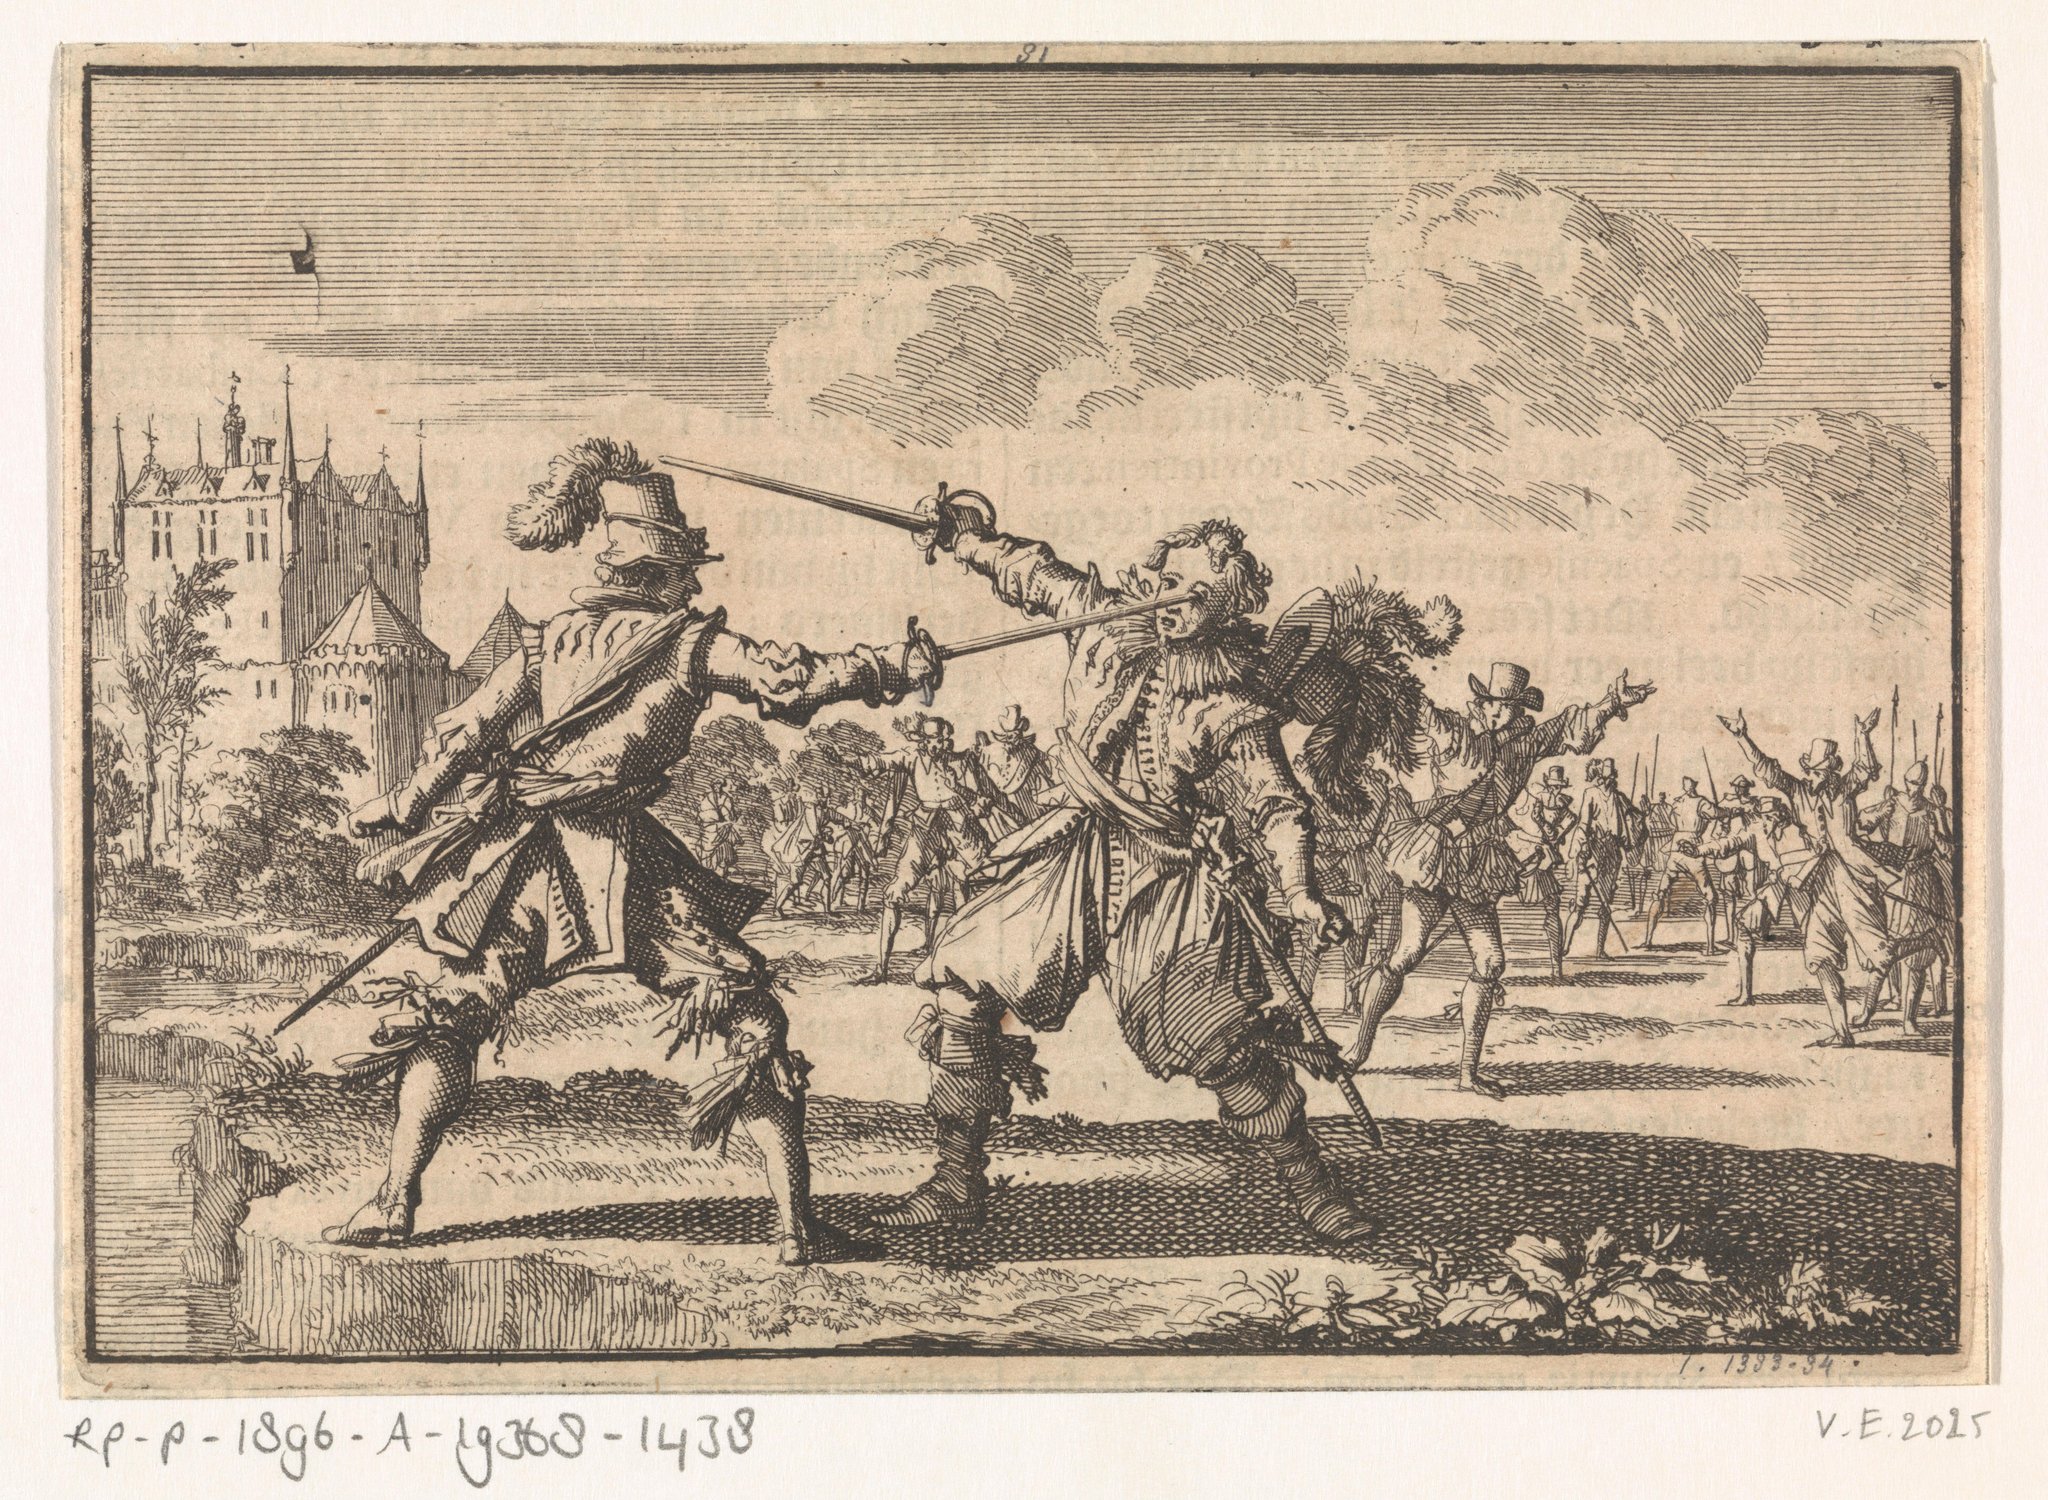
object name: book illustration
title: Rudolf Christiaan van Oost-Friesland in een twist gedood door een wond aan zijn oog, 1628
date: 1698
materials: paper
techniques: etching, letterpress printing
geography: amsterdam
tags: earl, violent death by sword, duelling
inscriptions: collector's mark: Lugt 2228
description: Illustratie uit: Gottfried, Johann Ludwig. Historische kronyck; vervattende een (...) beschrijvingh der aldergedenckwaerdigste geschiedenissen des weerelds, van den aenvangh der scheppingh tot (...) 1576 (2 delen). Leiden: Pieter van der Aa, 1698, dl. I, p. 1383.